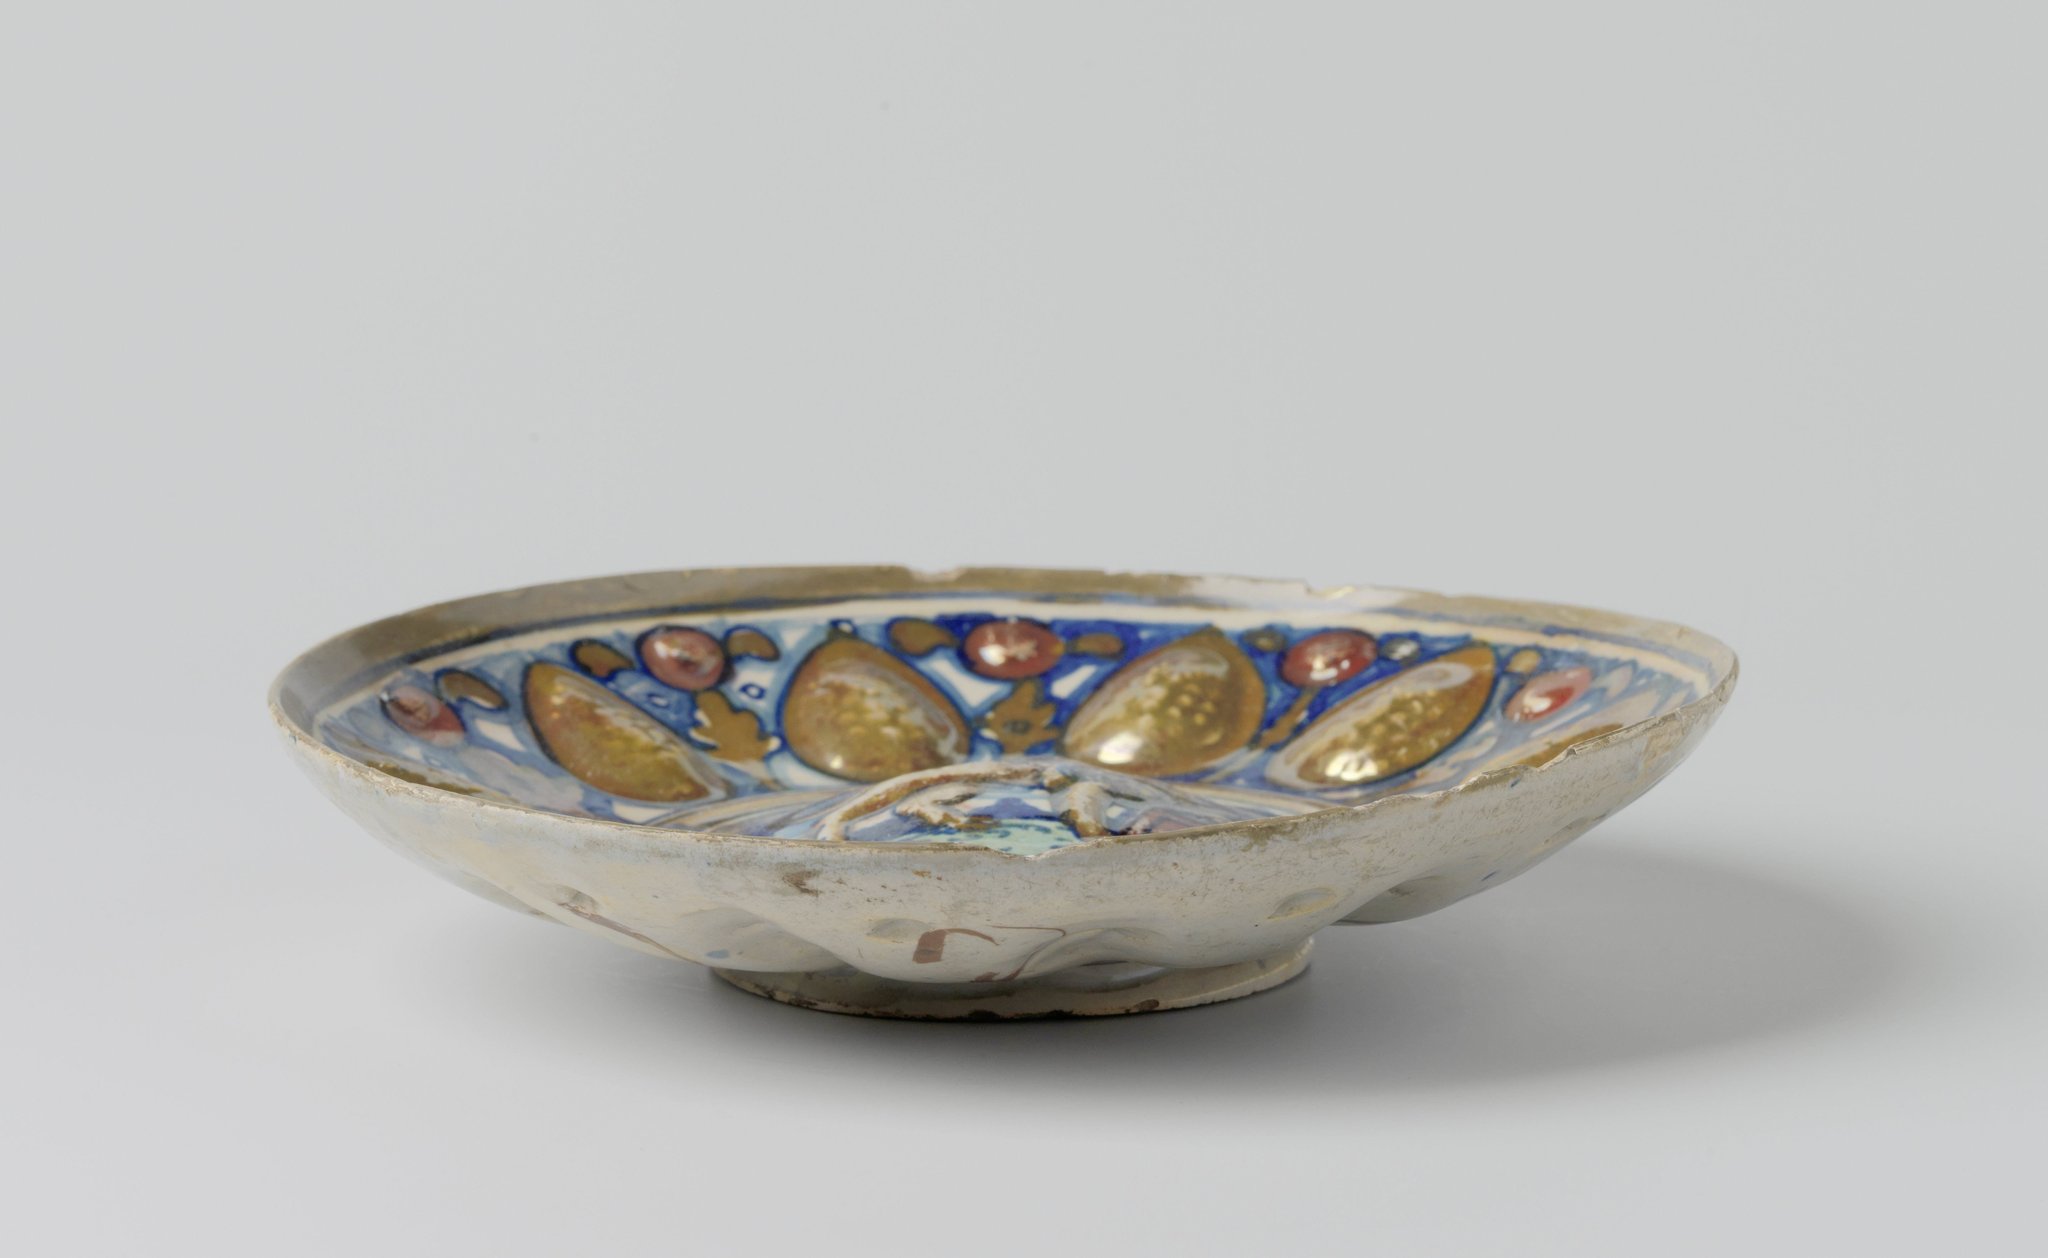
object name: platter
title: Schotel, veelkleurig en met reflet metallique beschilderd met een leeuw met zijn linker voorpoot op een boek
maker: Anonymous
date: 1530-1540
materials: earthenware, glaze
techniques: maiolica, painted, polychromy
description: Dish. Maiolica with additional decoration in metallic lustre. Gubbio, c. 1530 - 1540.